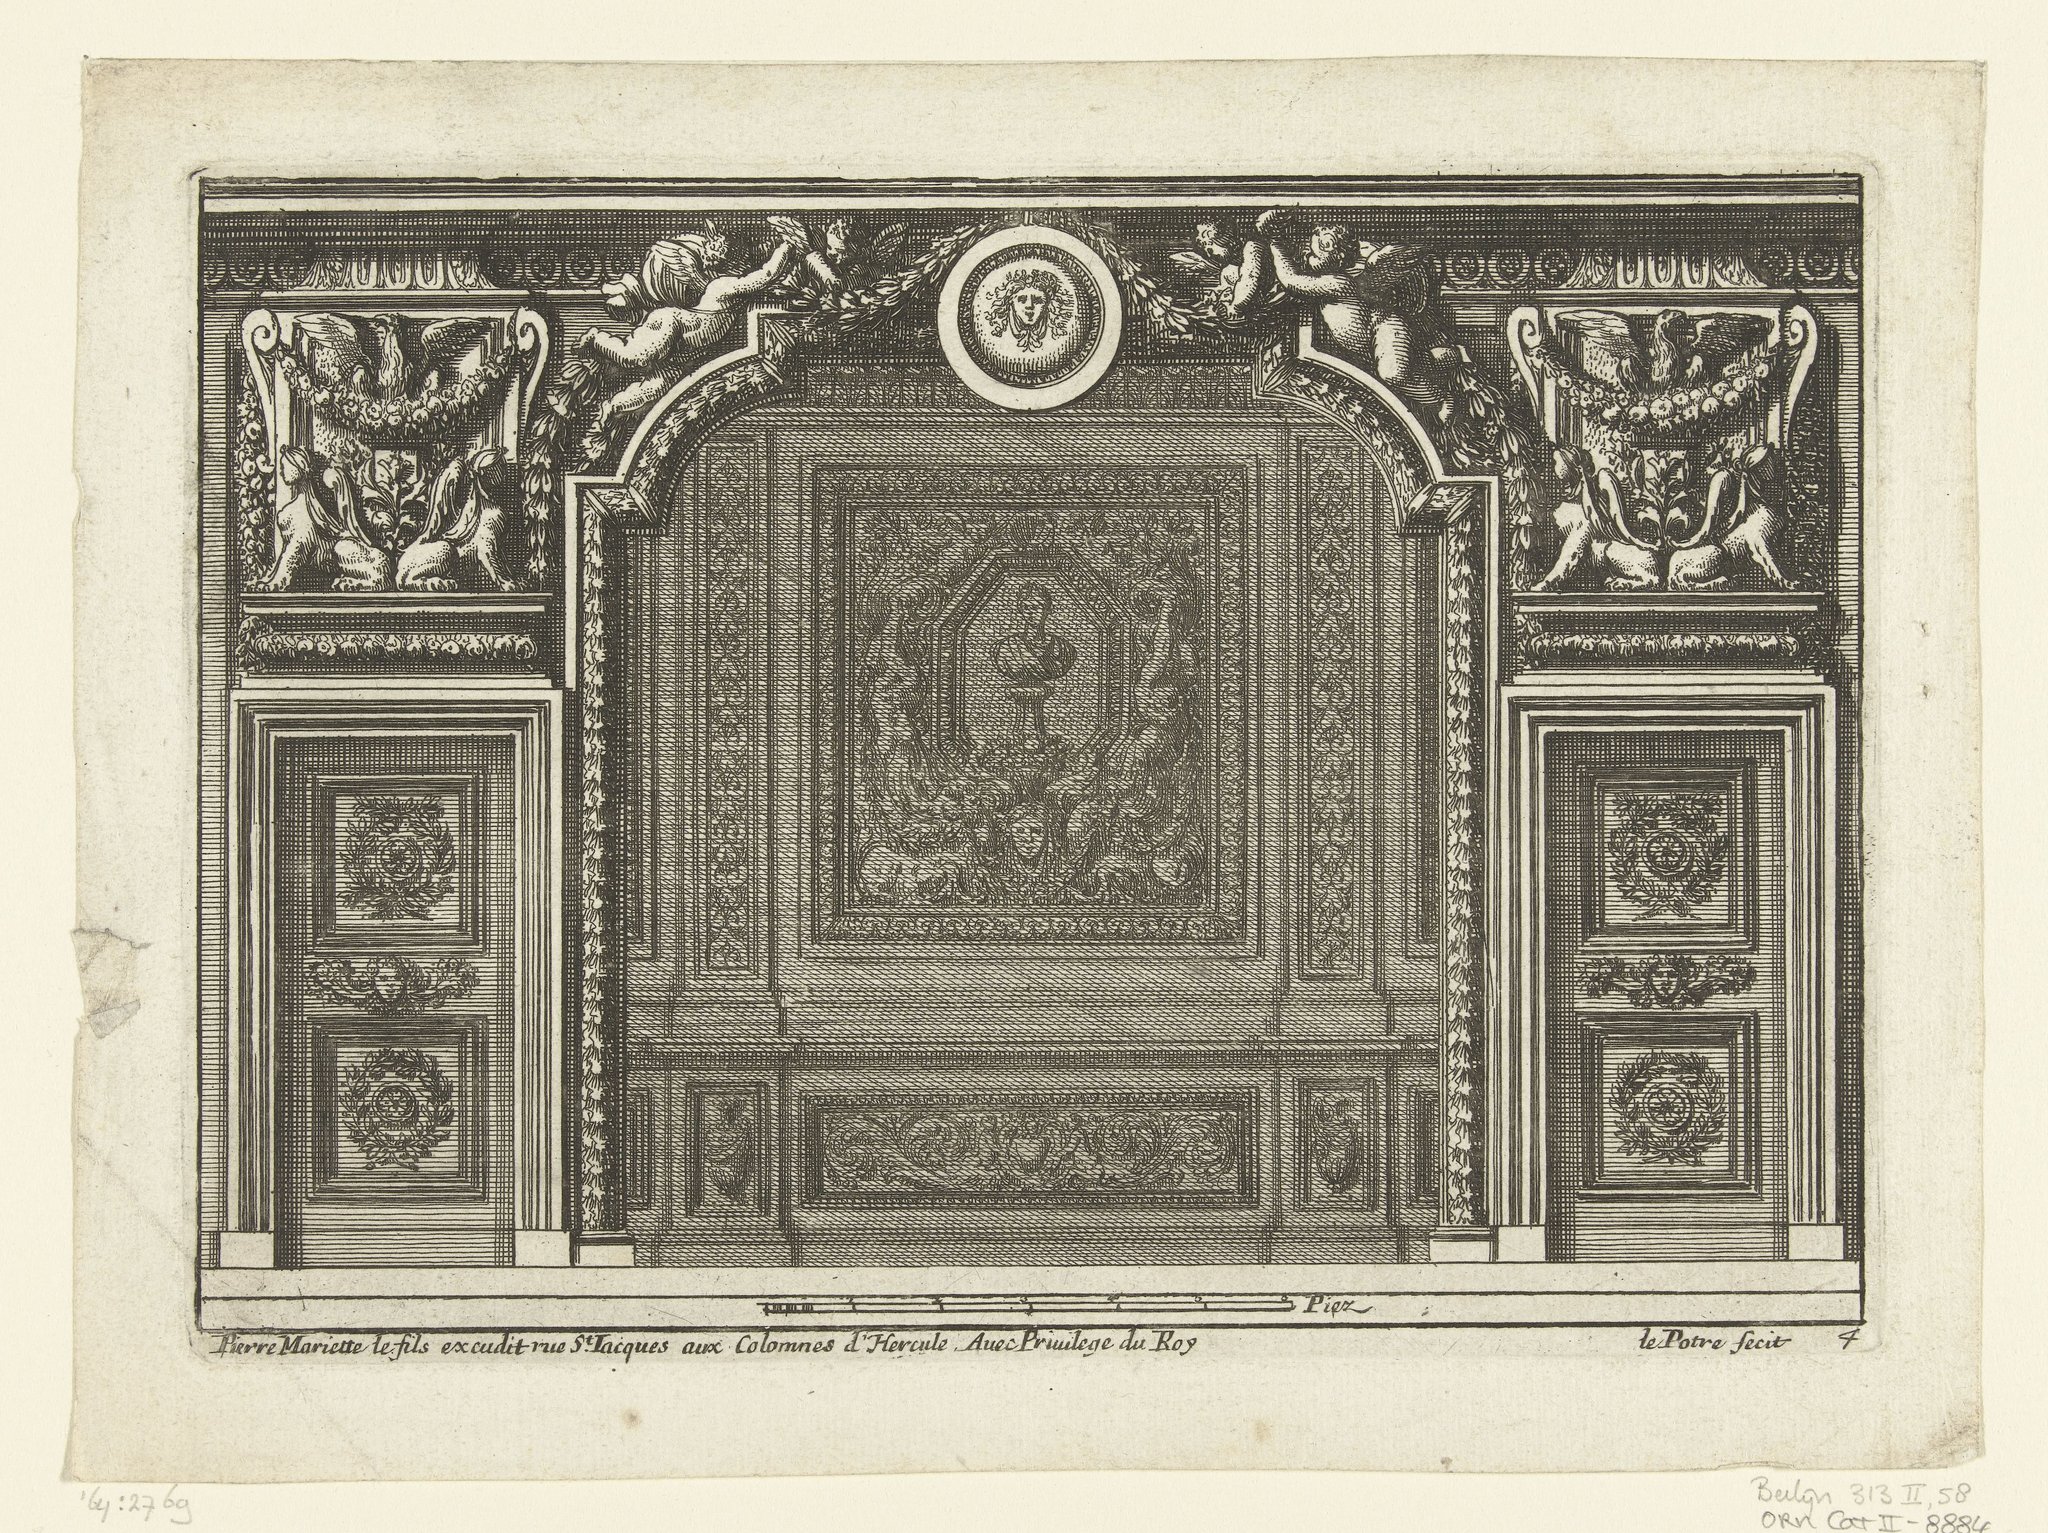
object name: print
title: Alcoues a l'Italiene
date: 1655-1657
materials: paper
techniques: etching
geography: paris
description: Aan weerskanten van de alkoof is een deur met een bovendeurspaneel, gedecoreerd met sfinxen, een adelaar en een guirlande.